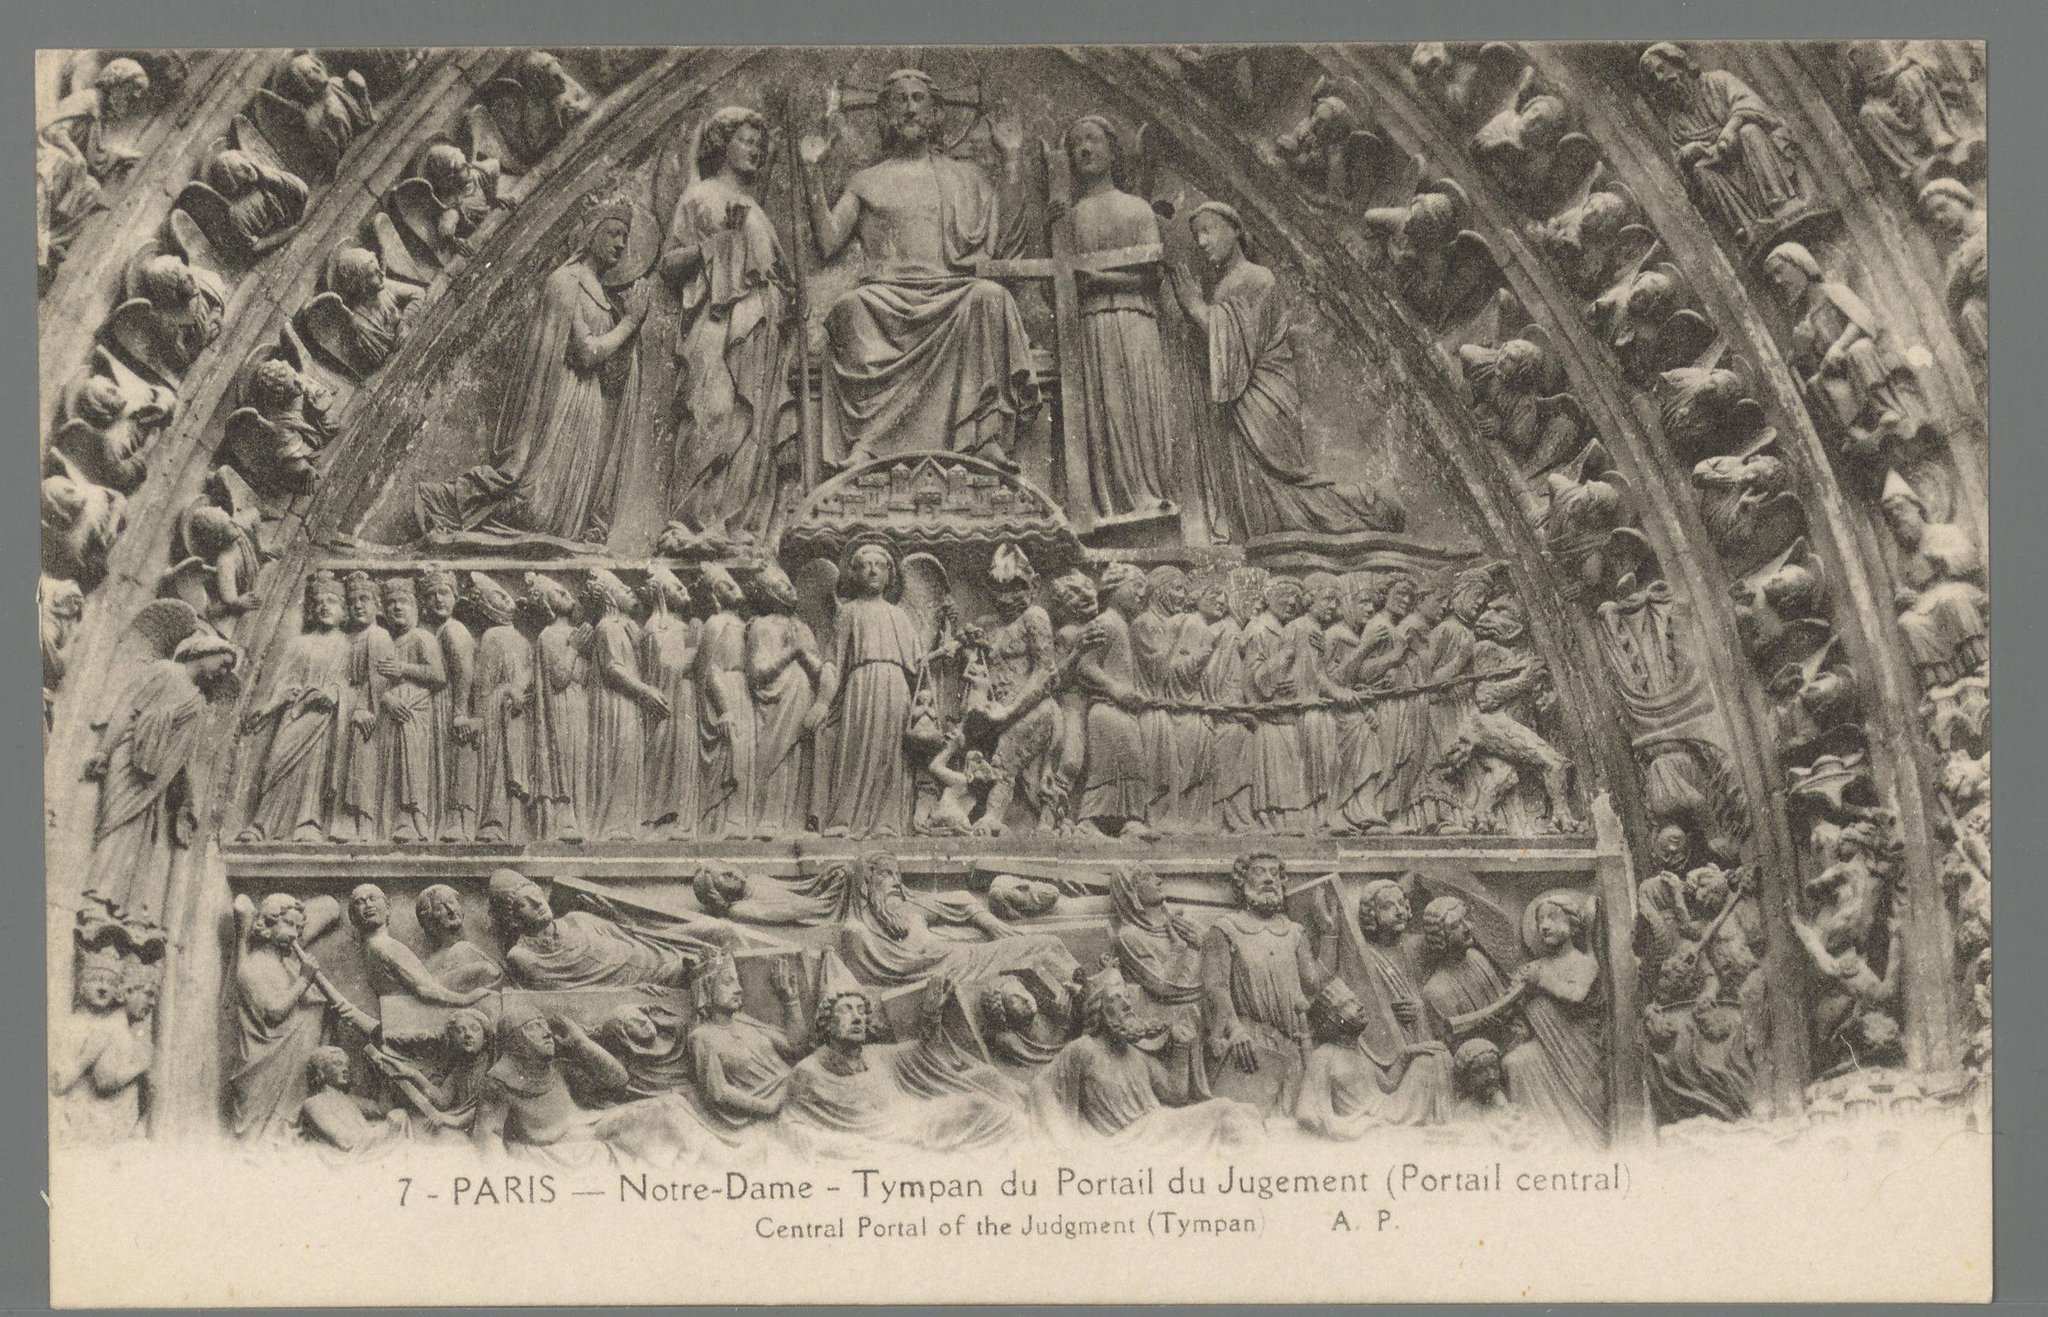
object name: photomechanical print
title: Paris - Notre-Dame - Tympan du portail du Jugement (portail central) / Central portal of the Judgment (tympan)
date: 1903-1930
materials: cardboard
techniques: photograph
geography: paris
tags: decorated gable, church (exterior)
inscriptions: collector's mark: ‘AFE v S’